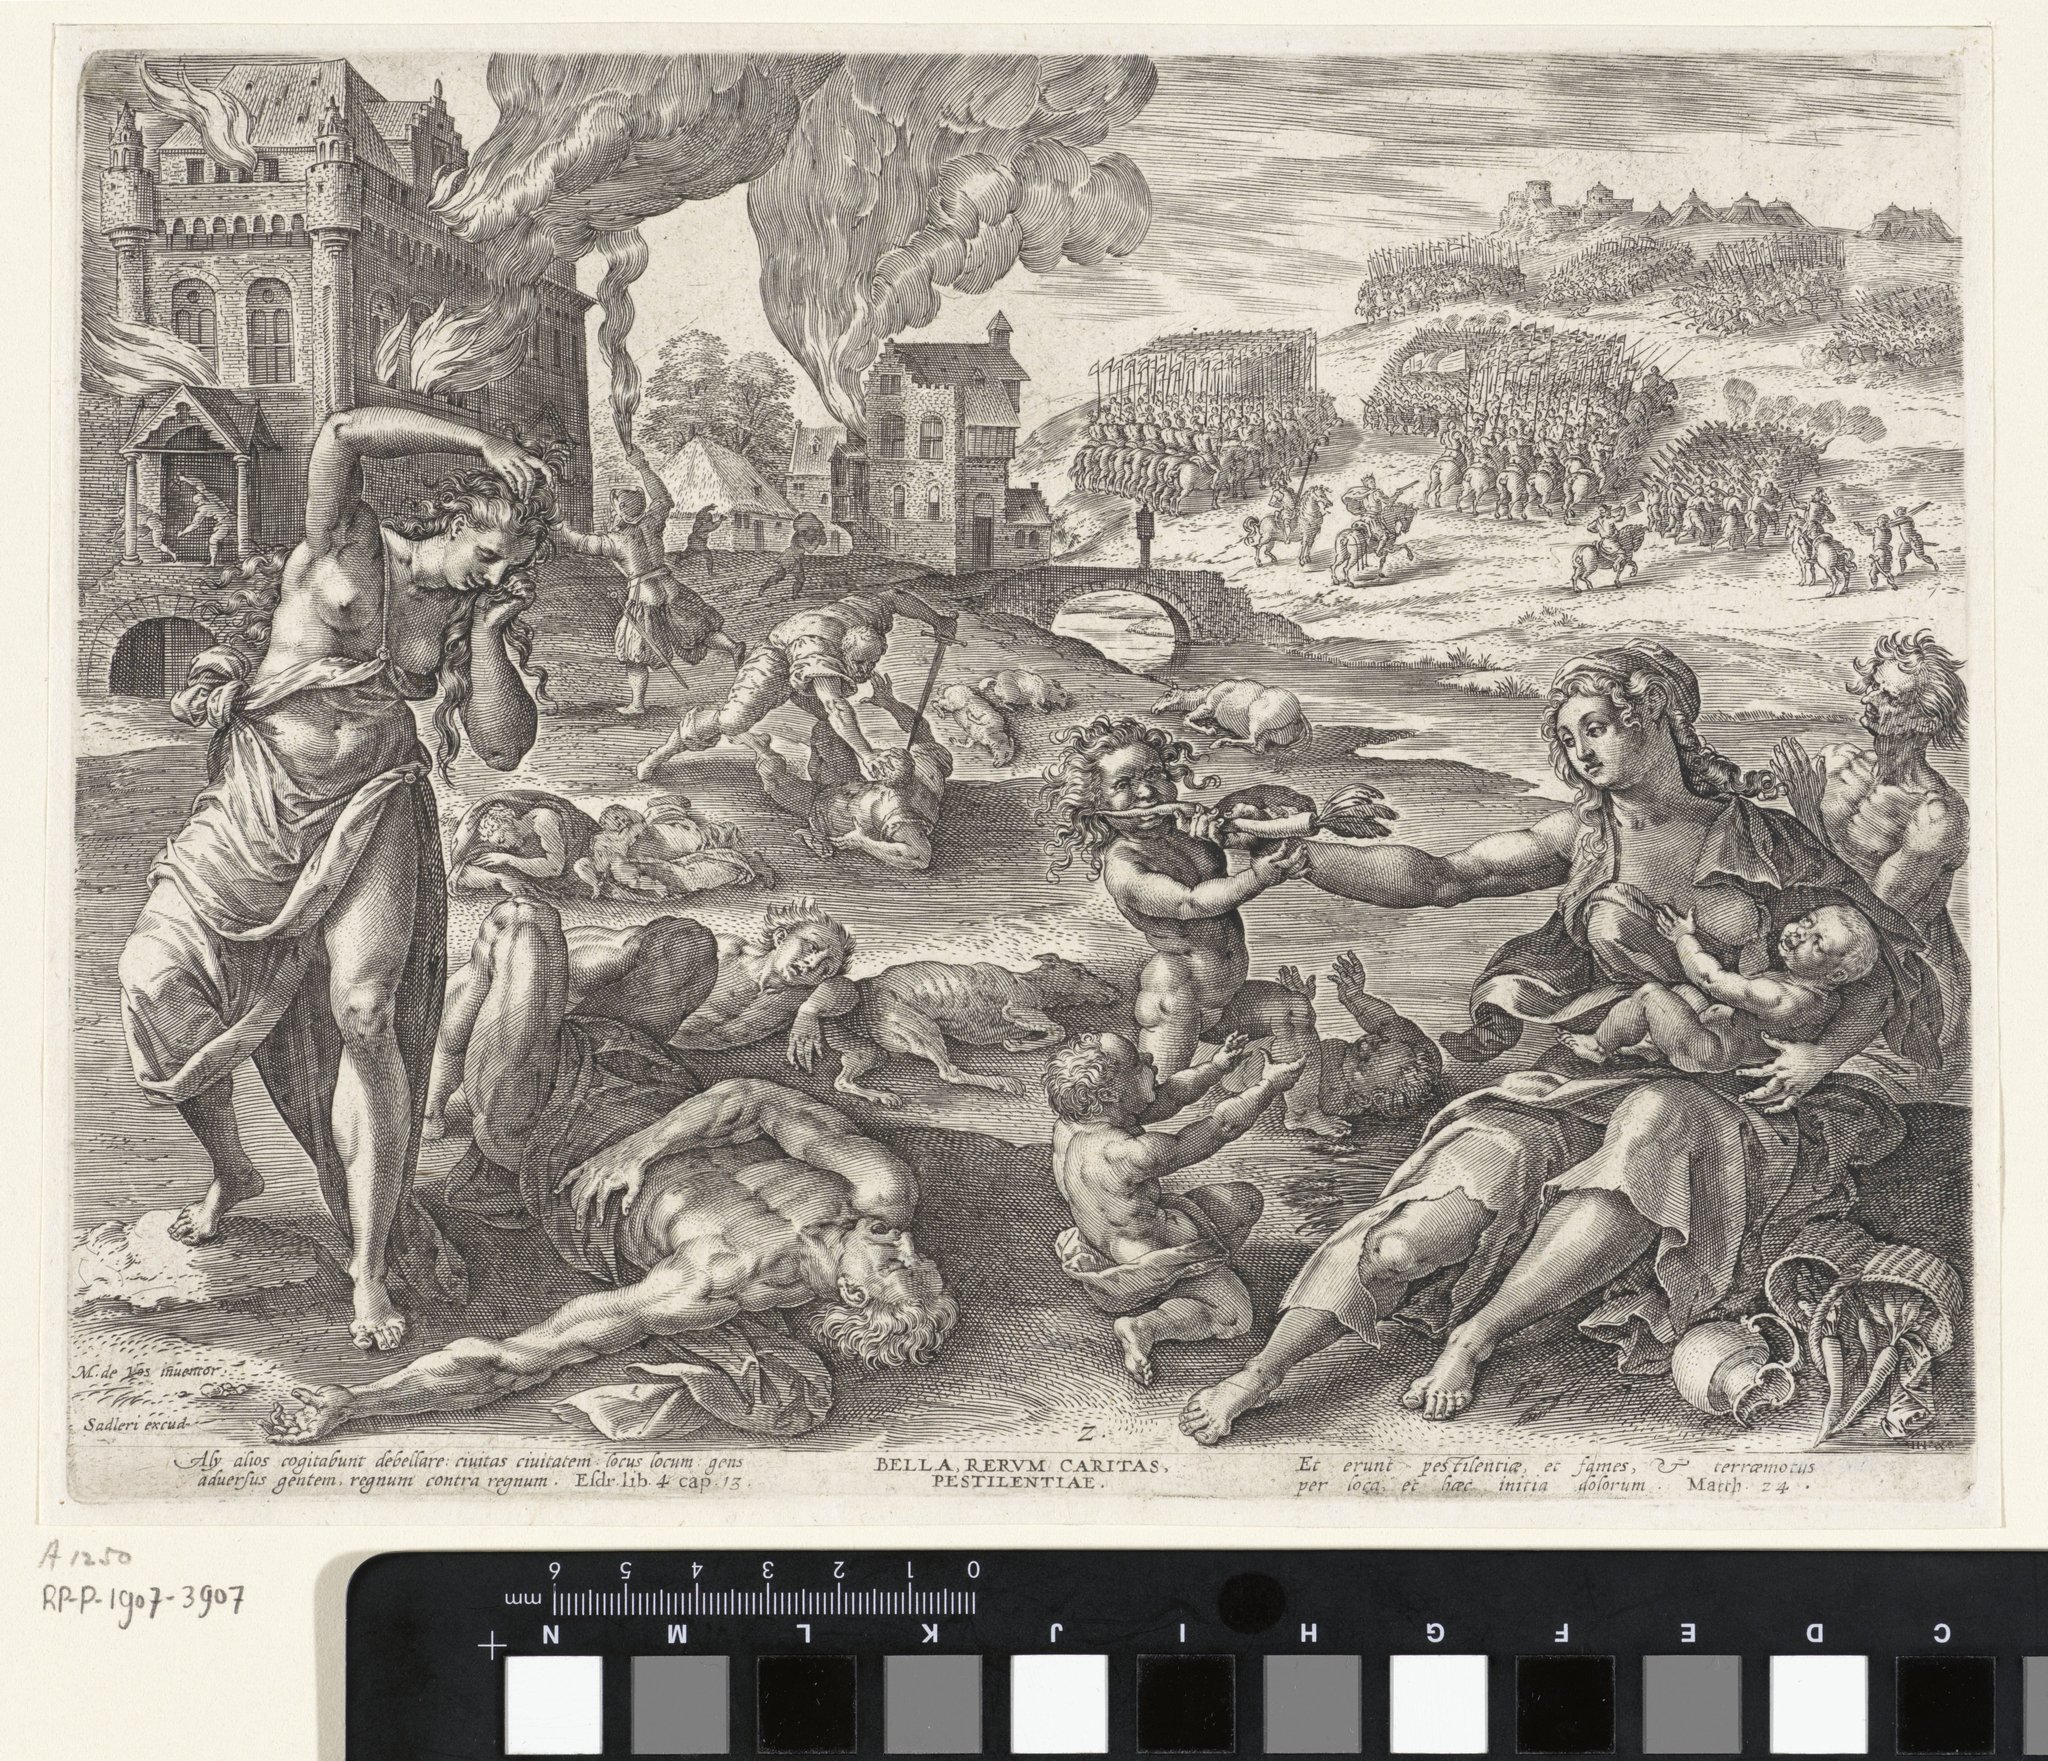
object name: print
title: Verschrikkingen van de oorlog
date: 1583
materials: paper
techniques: engraving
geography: antwerp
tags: horrors of war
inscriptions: collector's mark: Lugt 2228, collector's mark: Lugt 2542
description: Een moeder houdt haar baby op de arm, ze voert het jonge kind naast haar een wortel. Andere kinderen kijken hongerig toe. Rond hen liggen dode, uitgemergelde mannen en vrouwen. Een vrouw trekt wanhopig aan haar haren. Links op de achtergrond een brandende, geplunderde stad. Rechts op de achtergrond wordt oorlog gevoerd. De cavalerie rijdt in blokformatie. In de marge Bijbelcitaten uit Ezra 4:13 en Mat. 24 in het Latijn.